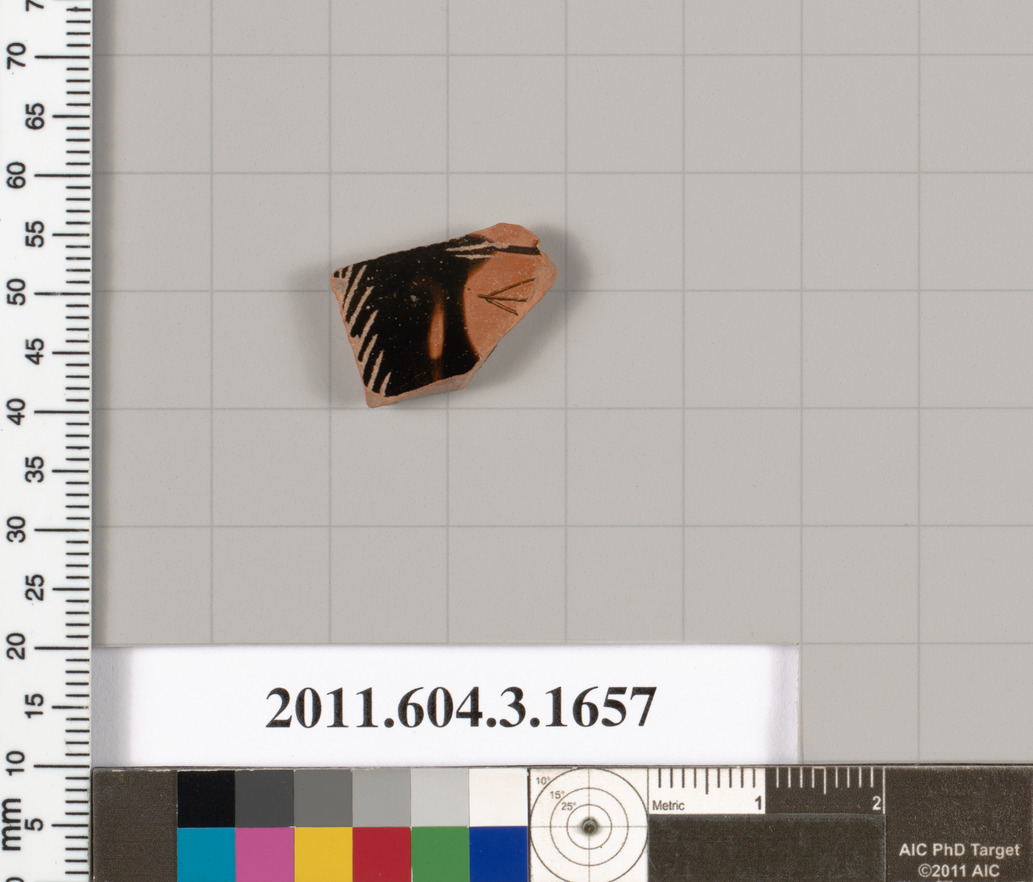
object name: kylix fragment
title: Terracotta fragment of a kylix: Band cup (drinking cup)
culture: greek, attic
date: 550-526 BCE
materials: terracotta